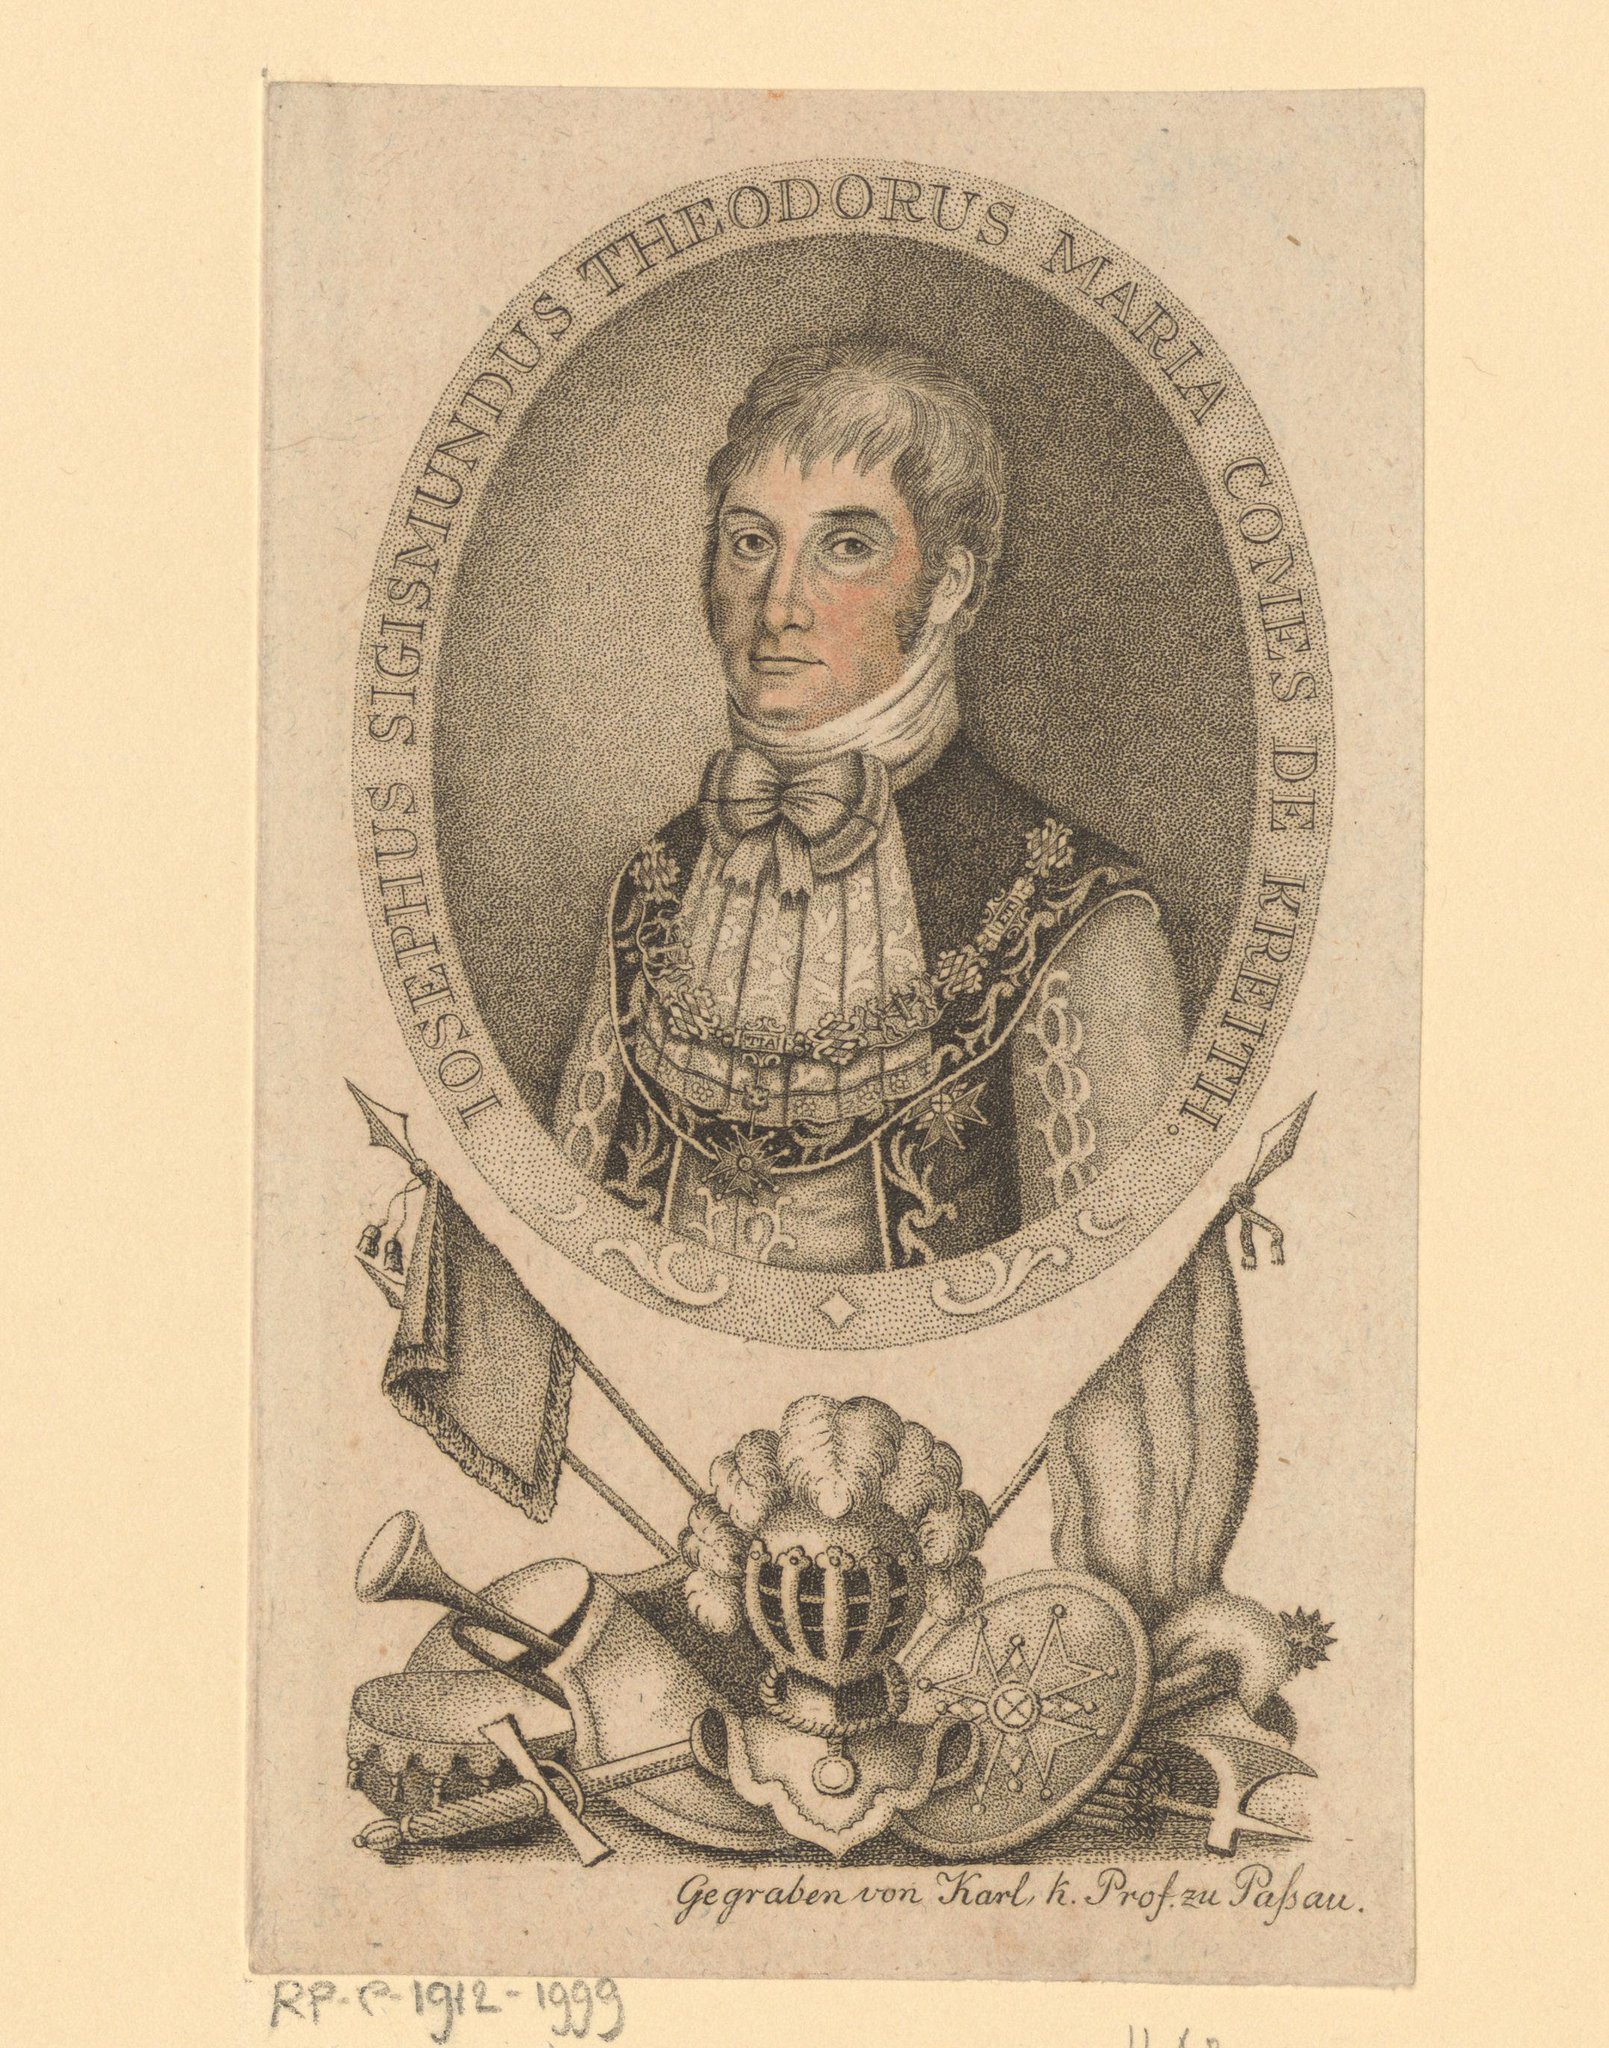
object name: print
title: Portret van Sigismund Joseph von Kreith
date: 1761-1849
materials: paper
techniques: engraving, hand coloring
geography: passau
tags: earl, helmet, historical persons, military clothing and other equipment (uniforms, cap, armour, helmet, etc.)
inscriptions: collector's mark: Lugt 2228